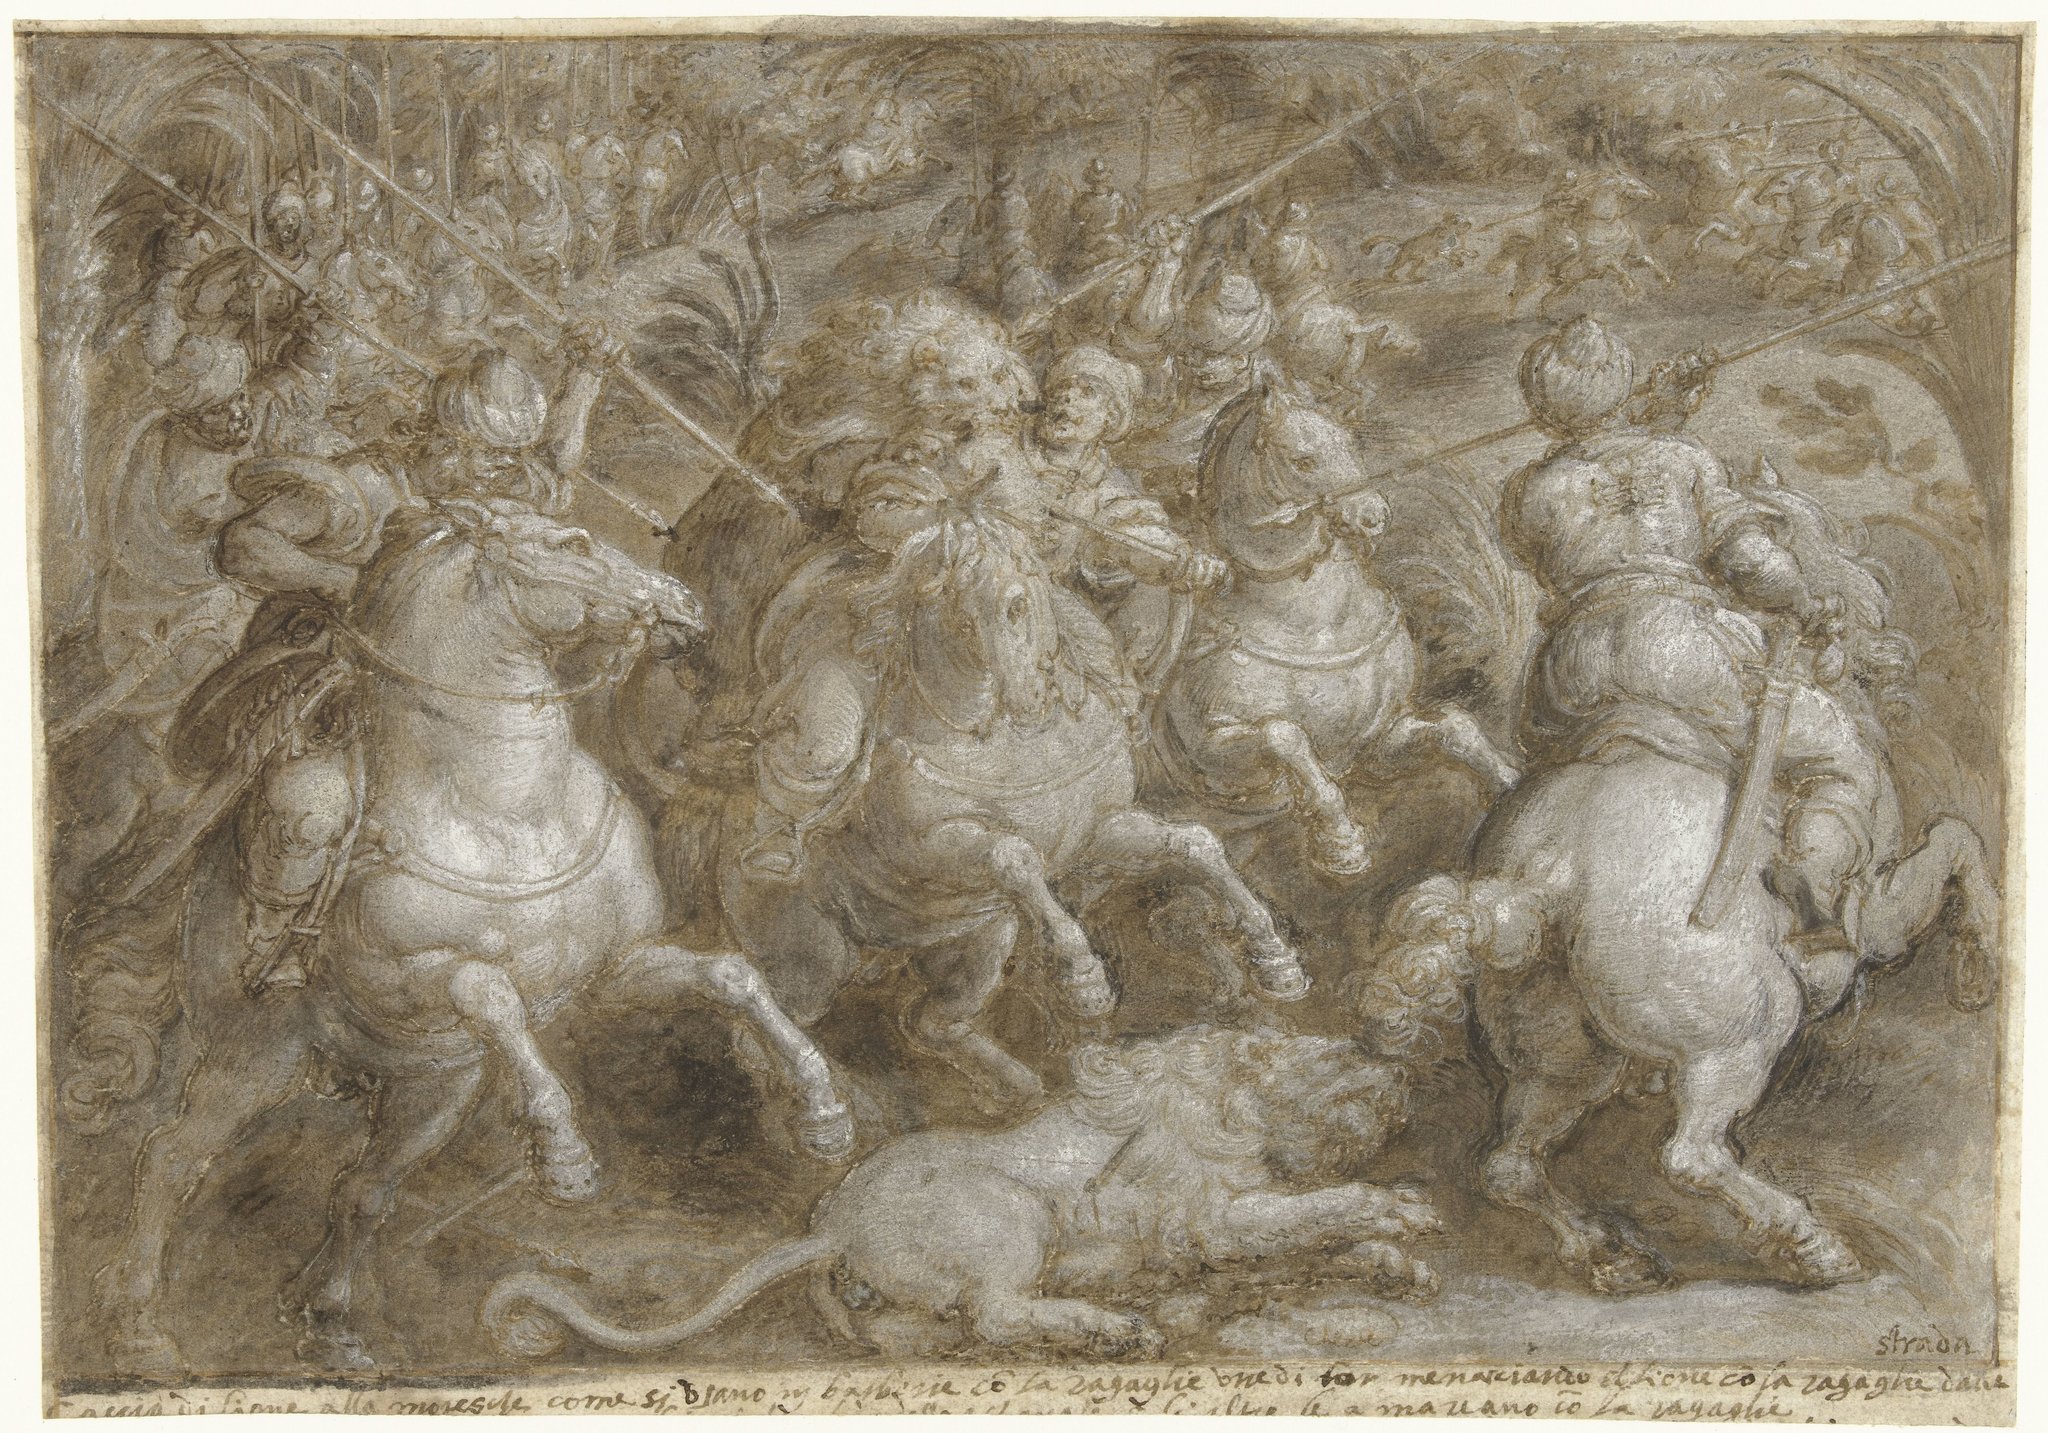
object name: design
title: Jacht op Perzische leeuwen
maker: jan van der straet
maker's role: draughtsman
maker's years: 1523-1605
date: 1533-1578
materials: ink, paint, paper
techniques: brush, pen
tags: lion hunt